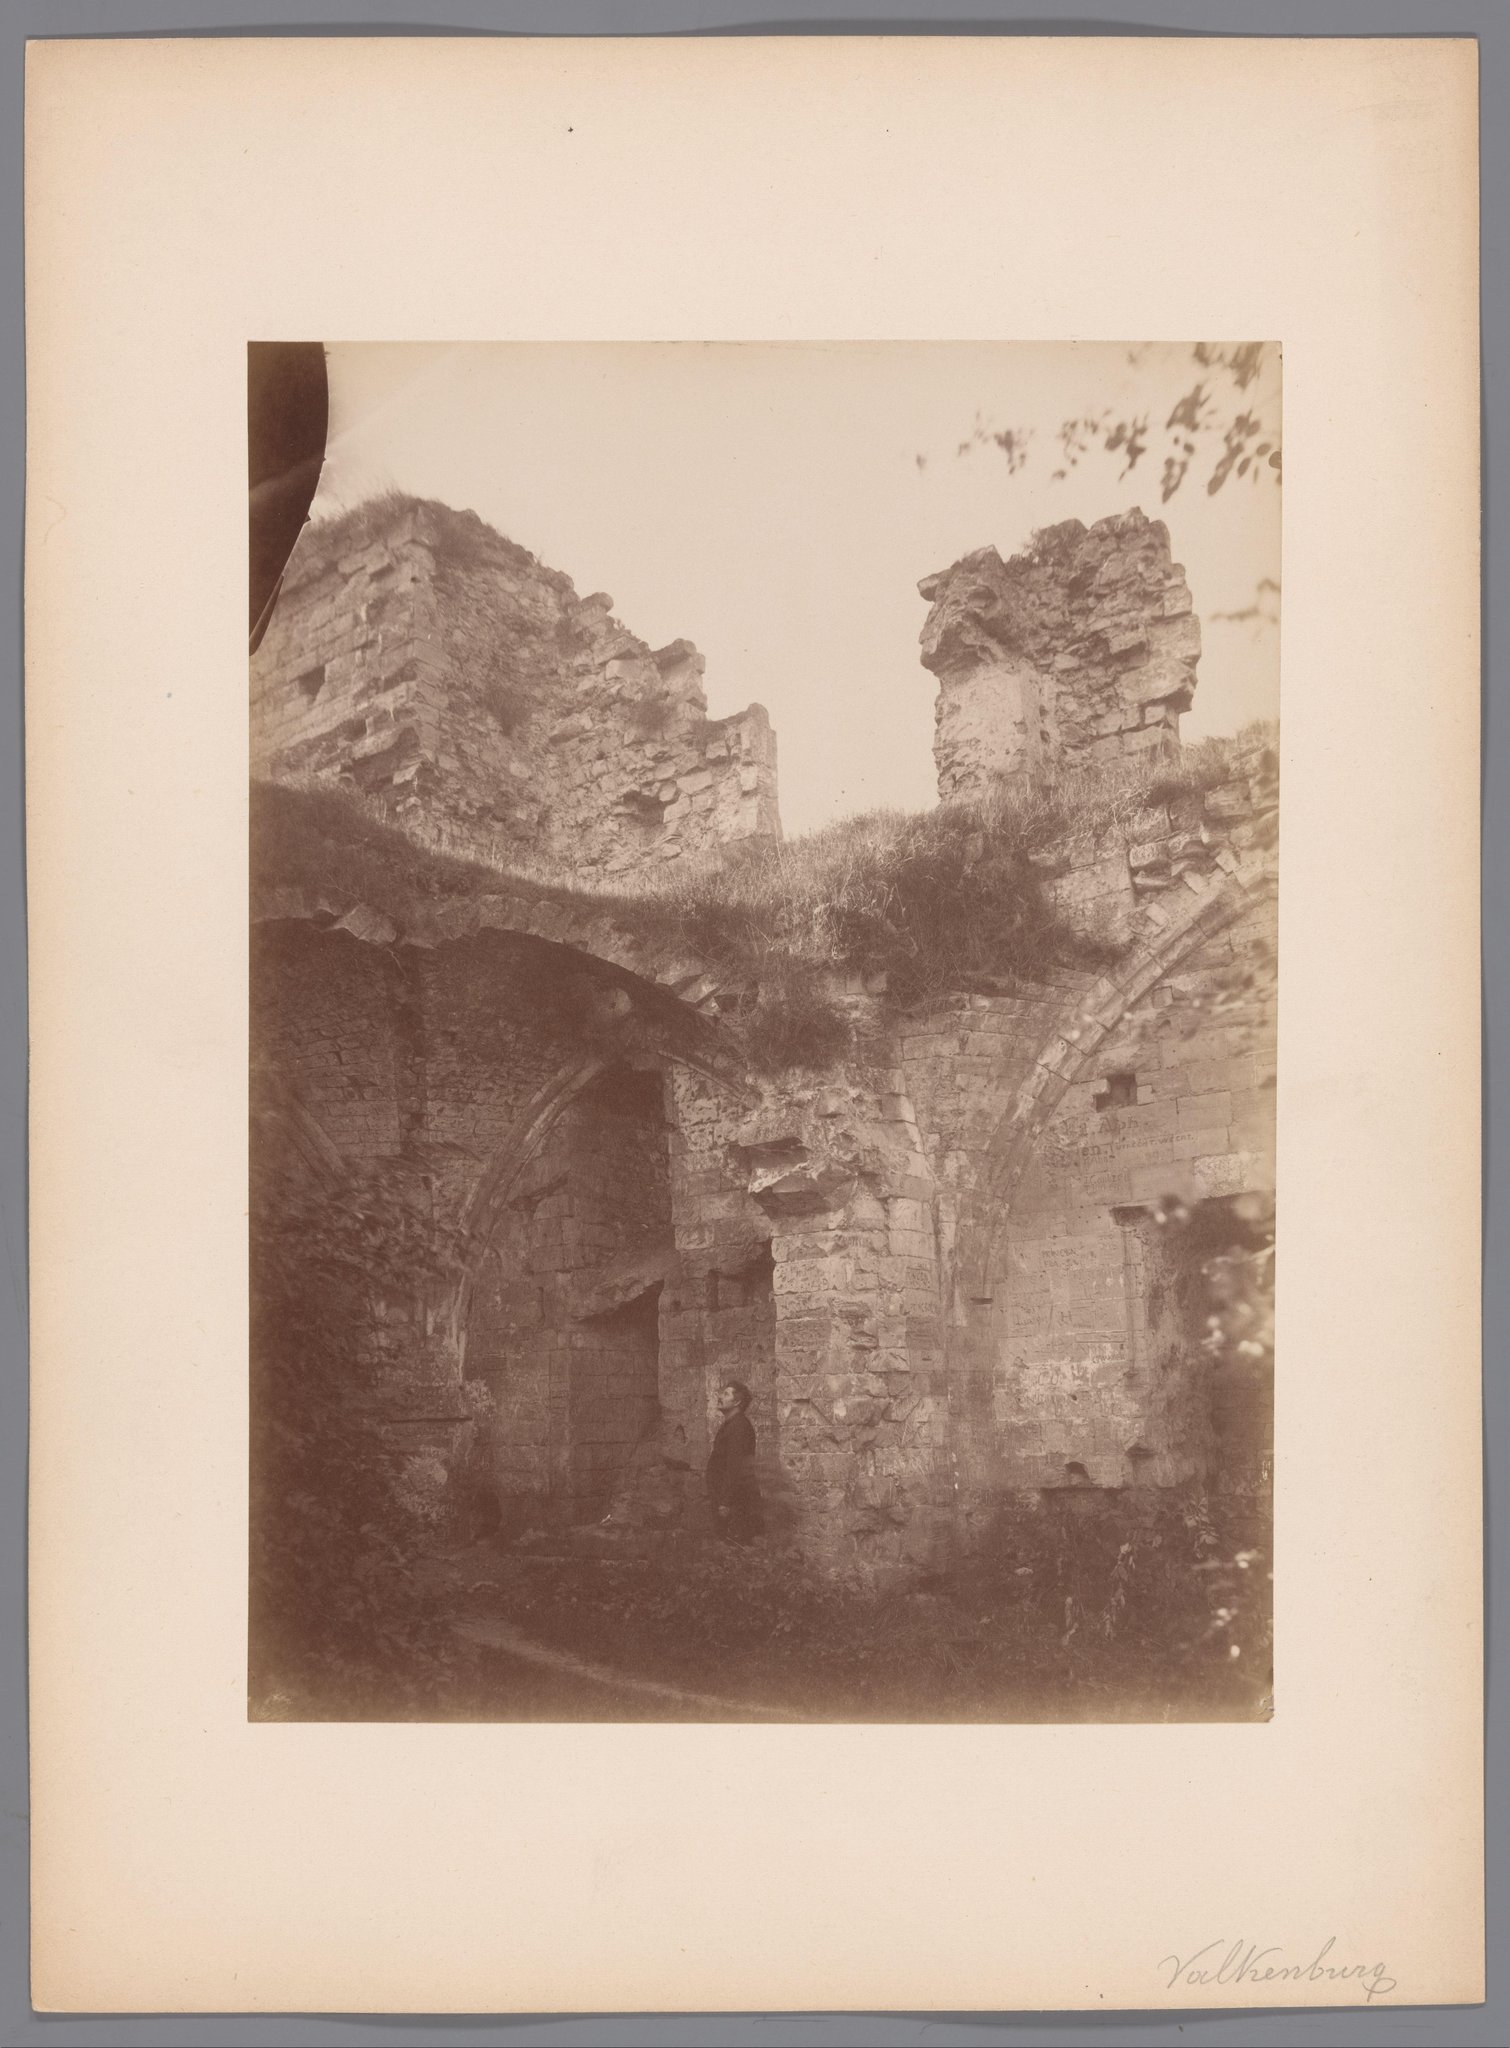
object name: photograph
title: Kapel van de kasteelruïne te Valkenburg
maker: anoniem (monumentenzorg)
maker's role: fotograaf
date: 1890-1920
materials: cardboard, photographic support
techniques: albumen print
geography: valkenburg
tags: ruin of a dwelling, house, castle, etc.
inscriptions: annotation: ‘Ruïne te Valkenburg/ aanzicht in de kapel’, annotation: ‘Valkenburg’